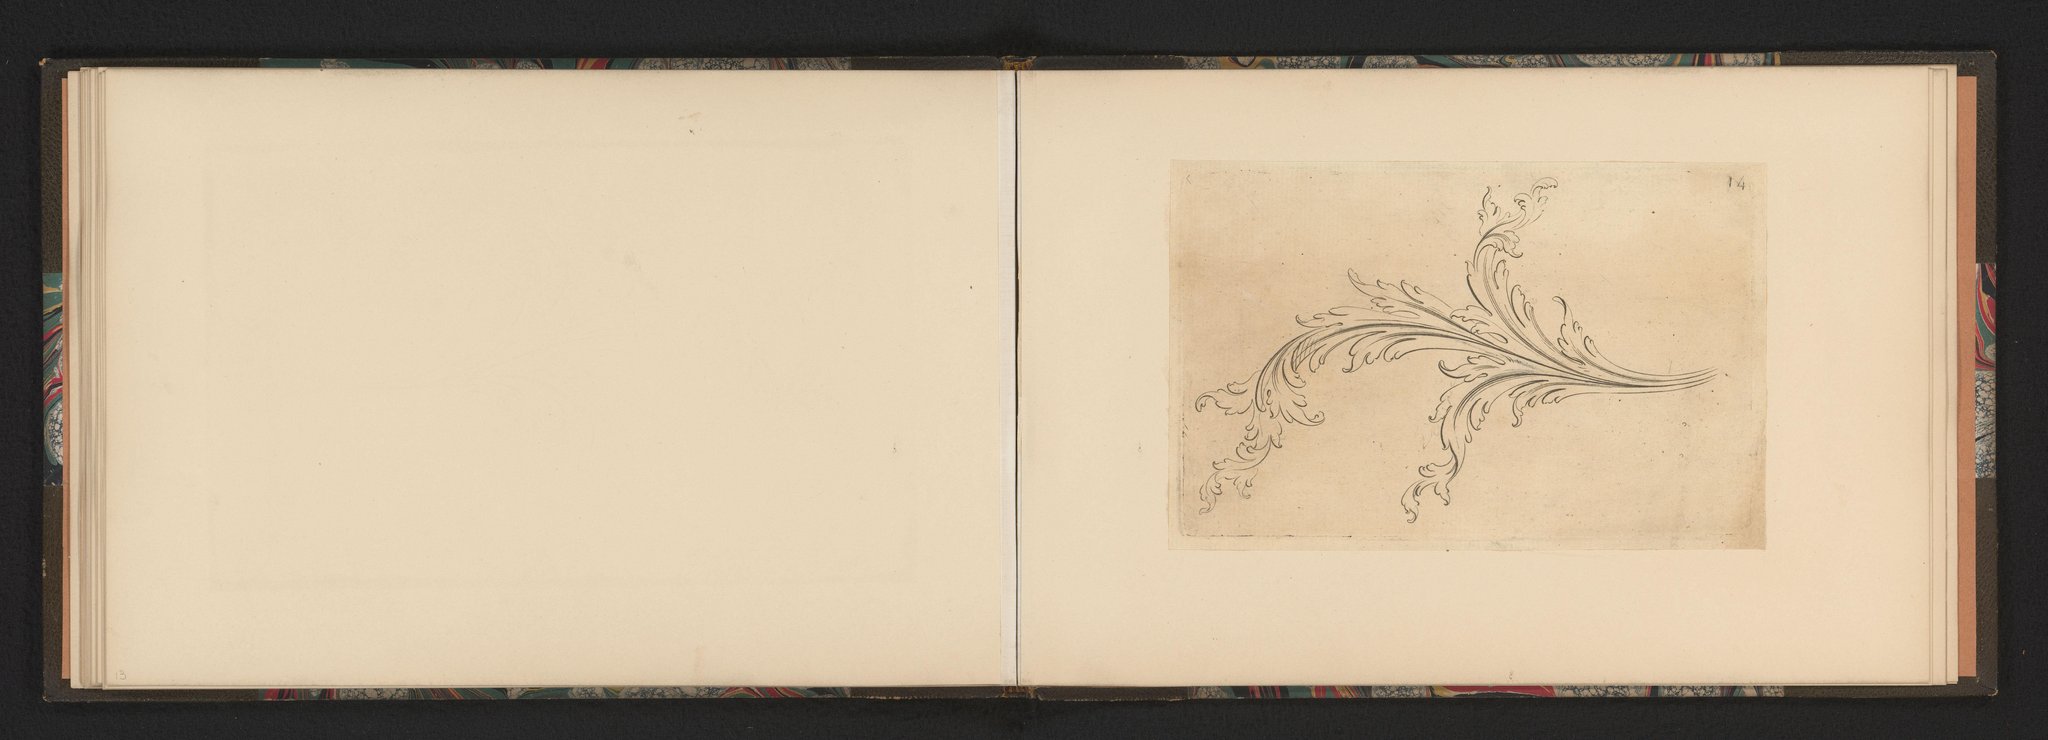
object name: ornament print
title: Ornamentele versiering van een blad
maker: p. baretti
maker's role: print maker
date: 1766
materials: paper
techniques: engraving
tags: ornaments ~ art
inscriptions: number: ‘14’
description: Ingeplakte prent met ornamentele versiering van een blad, schematisch weergegeven. Prent maakt deel uit van een album.